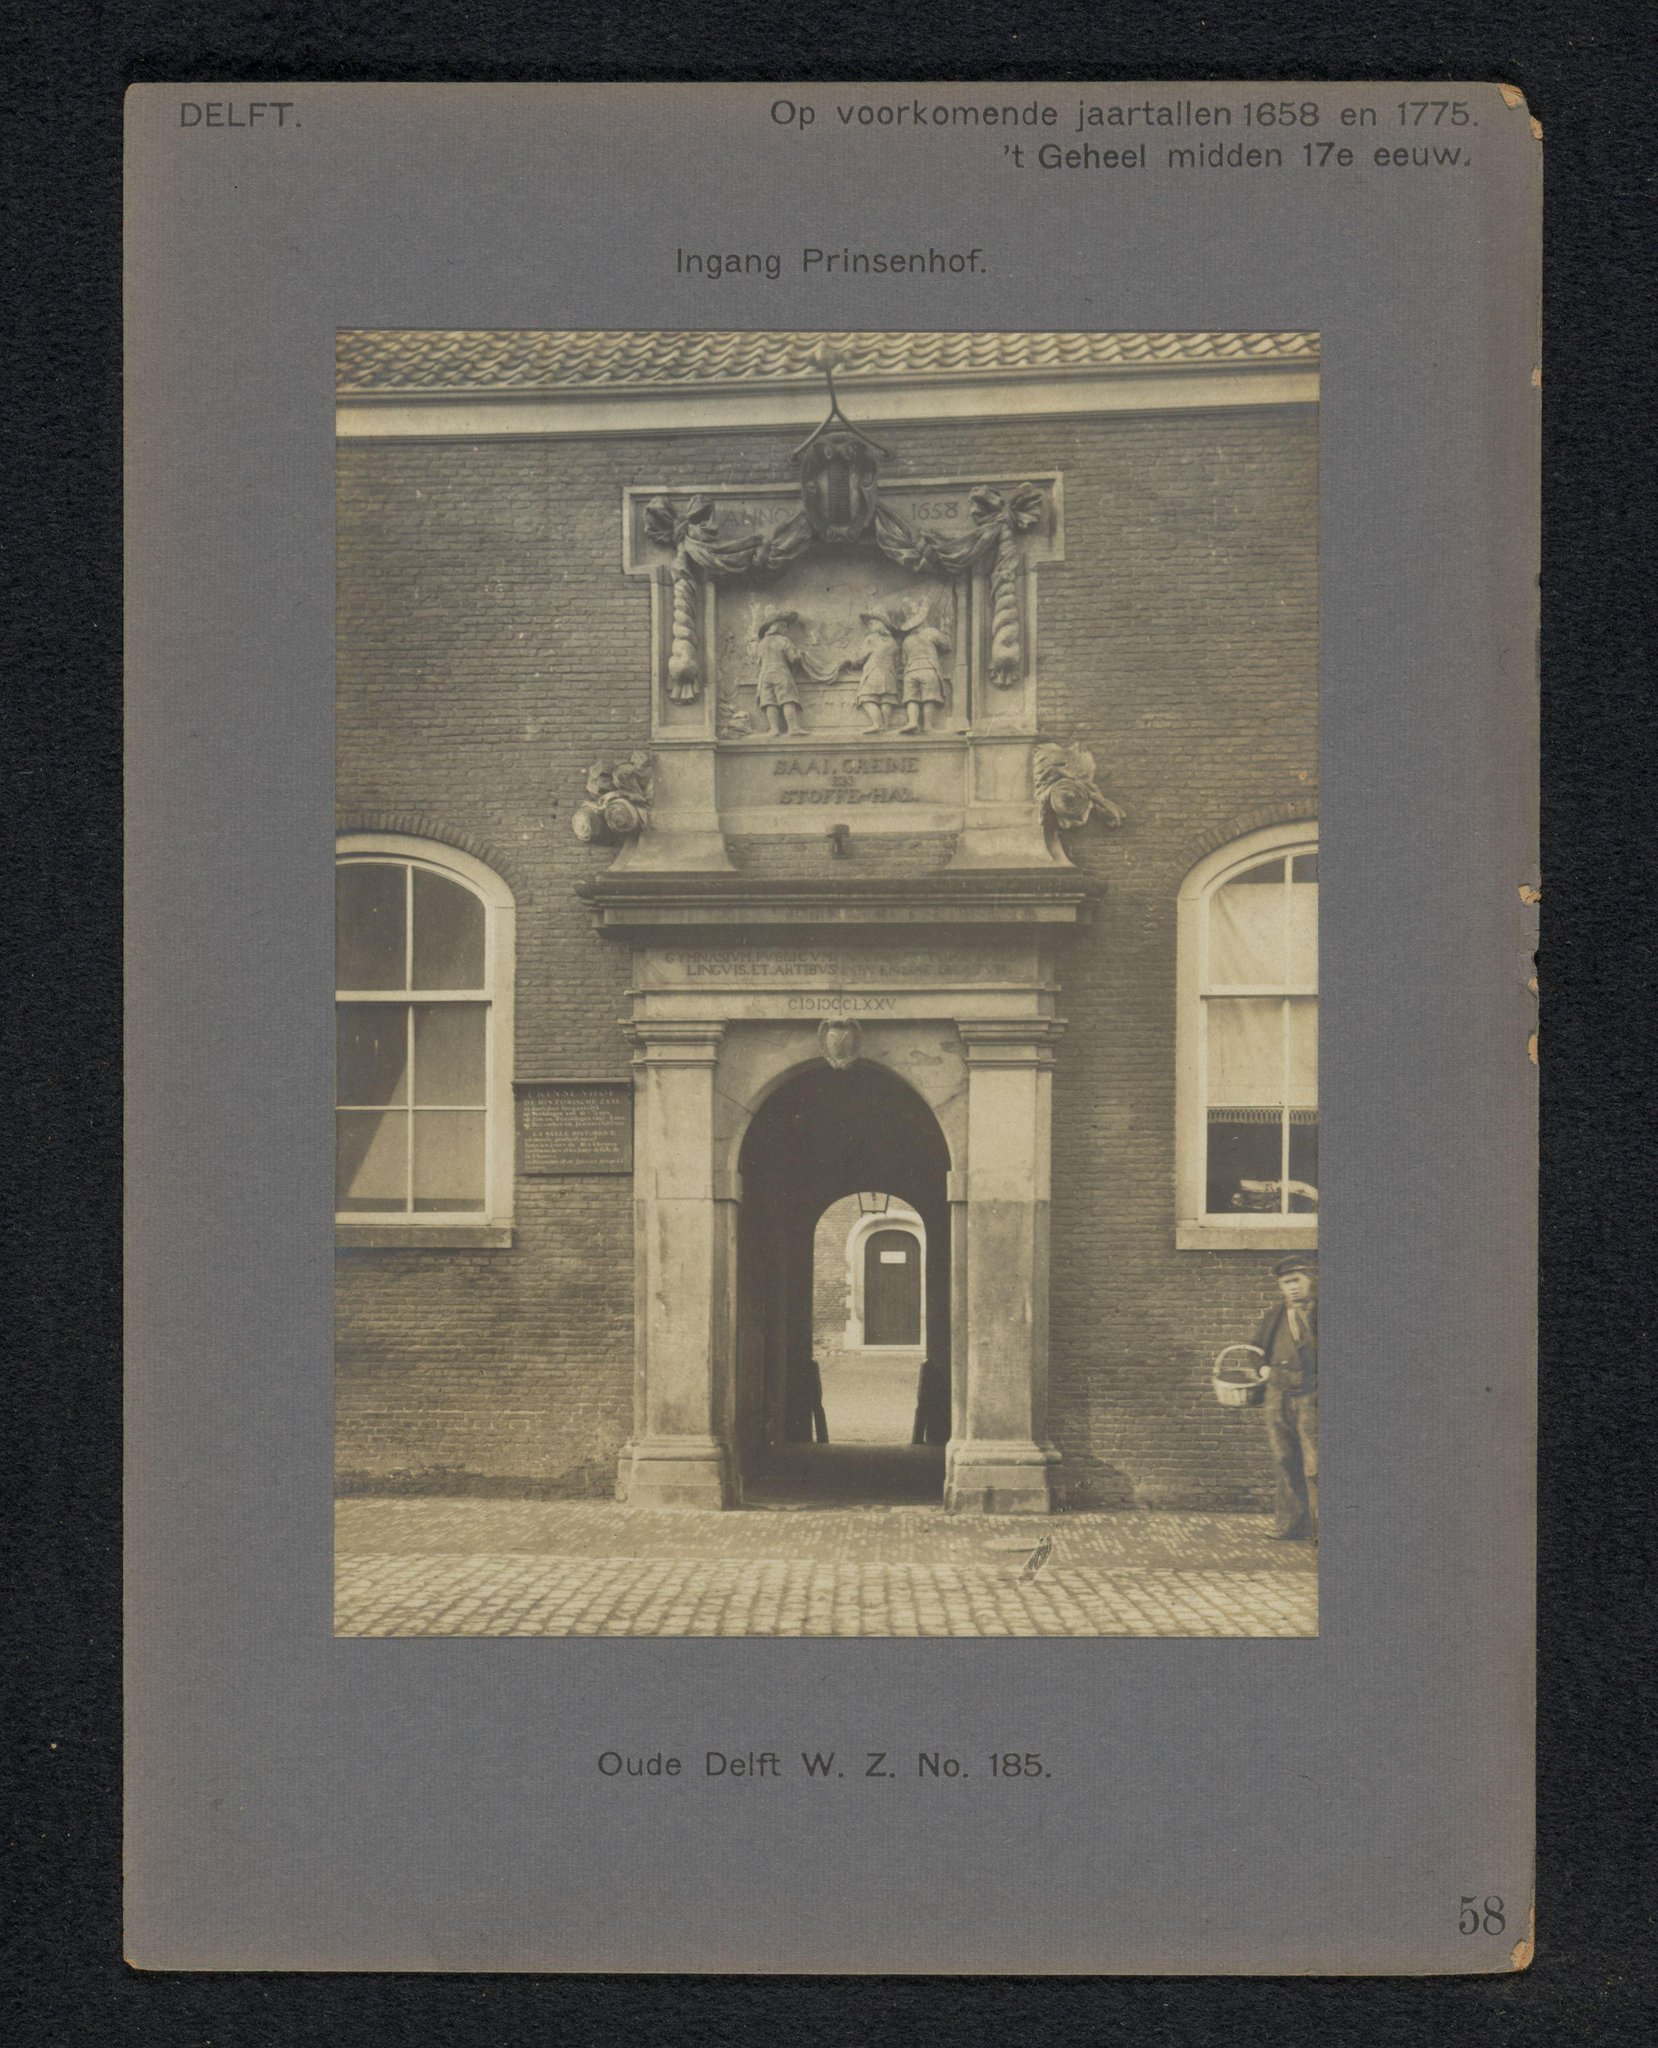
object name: photograph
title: Poort van het Prinsenhof in Delft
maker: Anonymous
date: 1900-1904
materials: cardboard, photographic support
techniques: gelatin silver print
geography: delft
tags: gate, entrance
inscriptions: number: ‘58’, inscription: ‘Het recht van reproductie dezer photo's wordt door den Uitgever voorbehouden.’, inscription: ‘Delft. Op voorkomende jaartallen 1658 en 1775. 't Geheel midden 17e eeuw,’